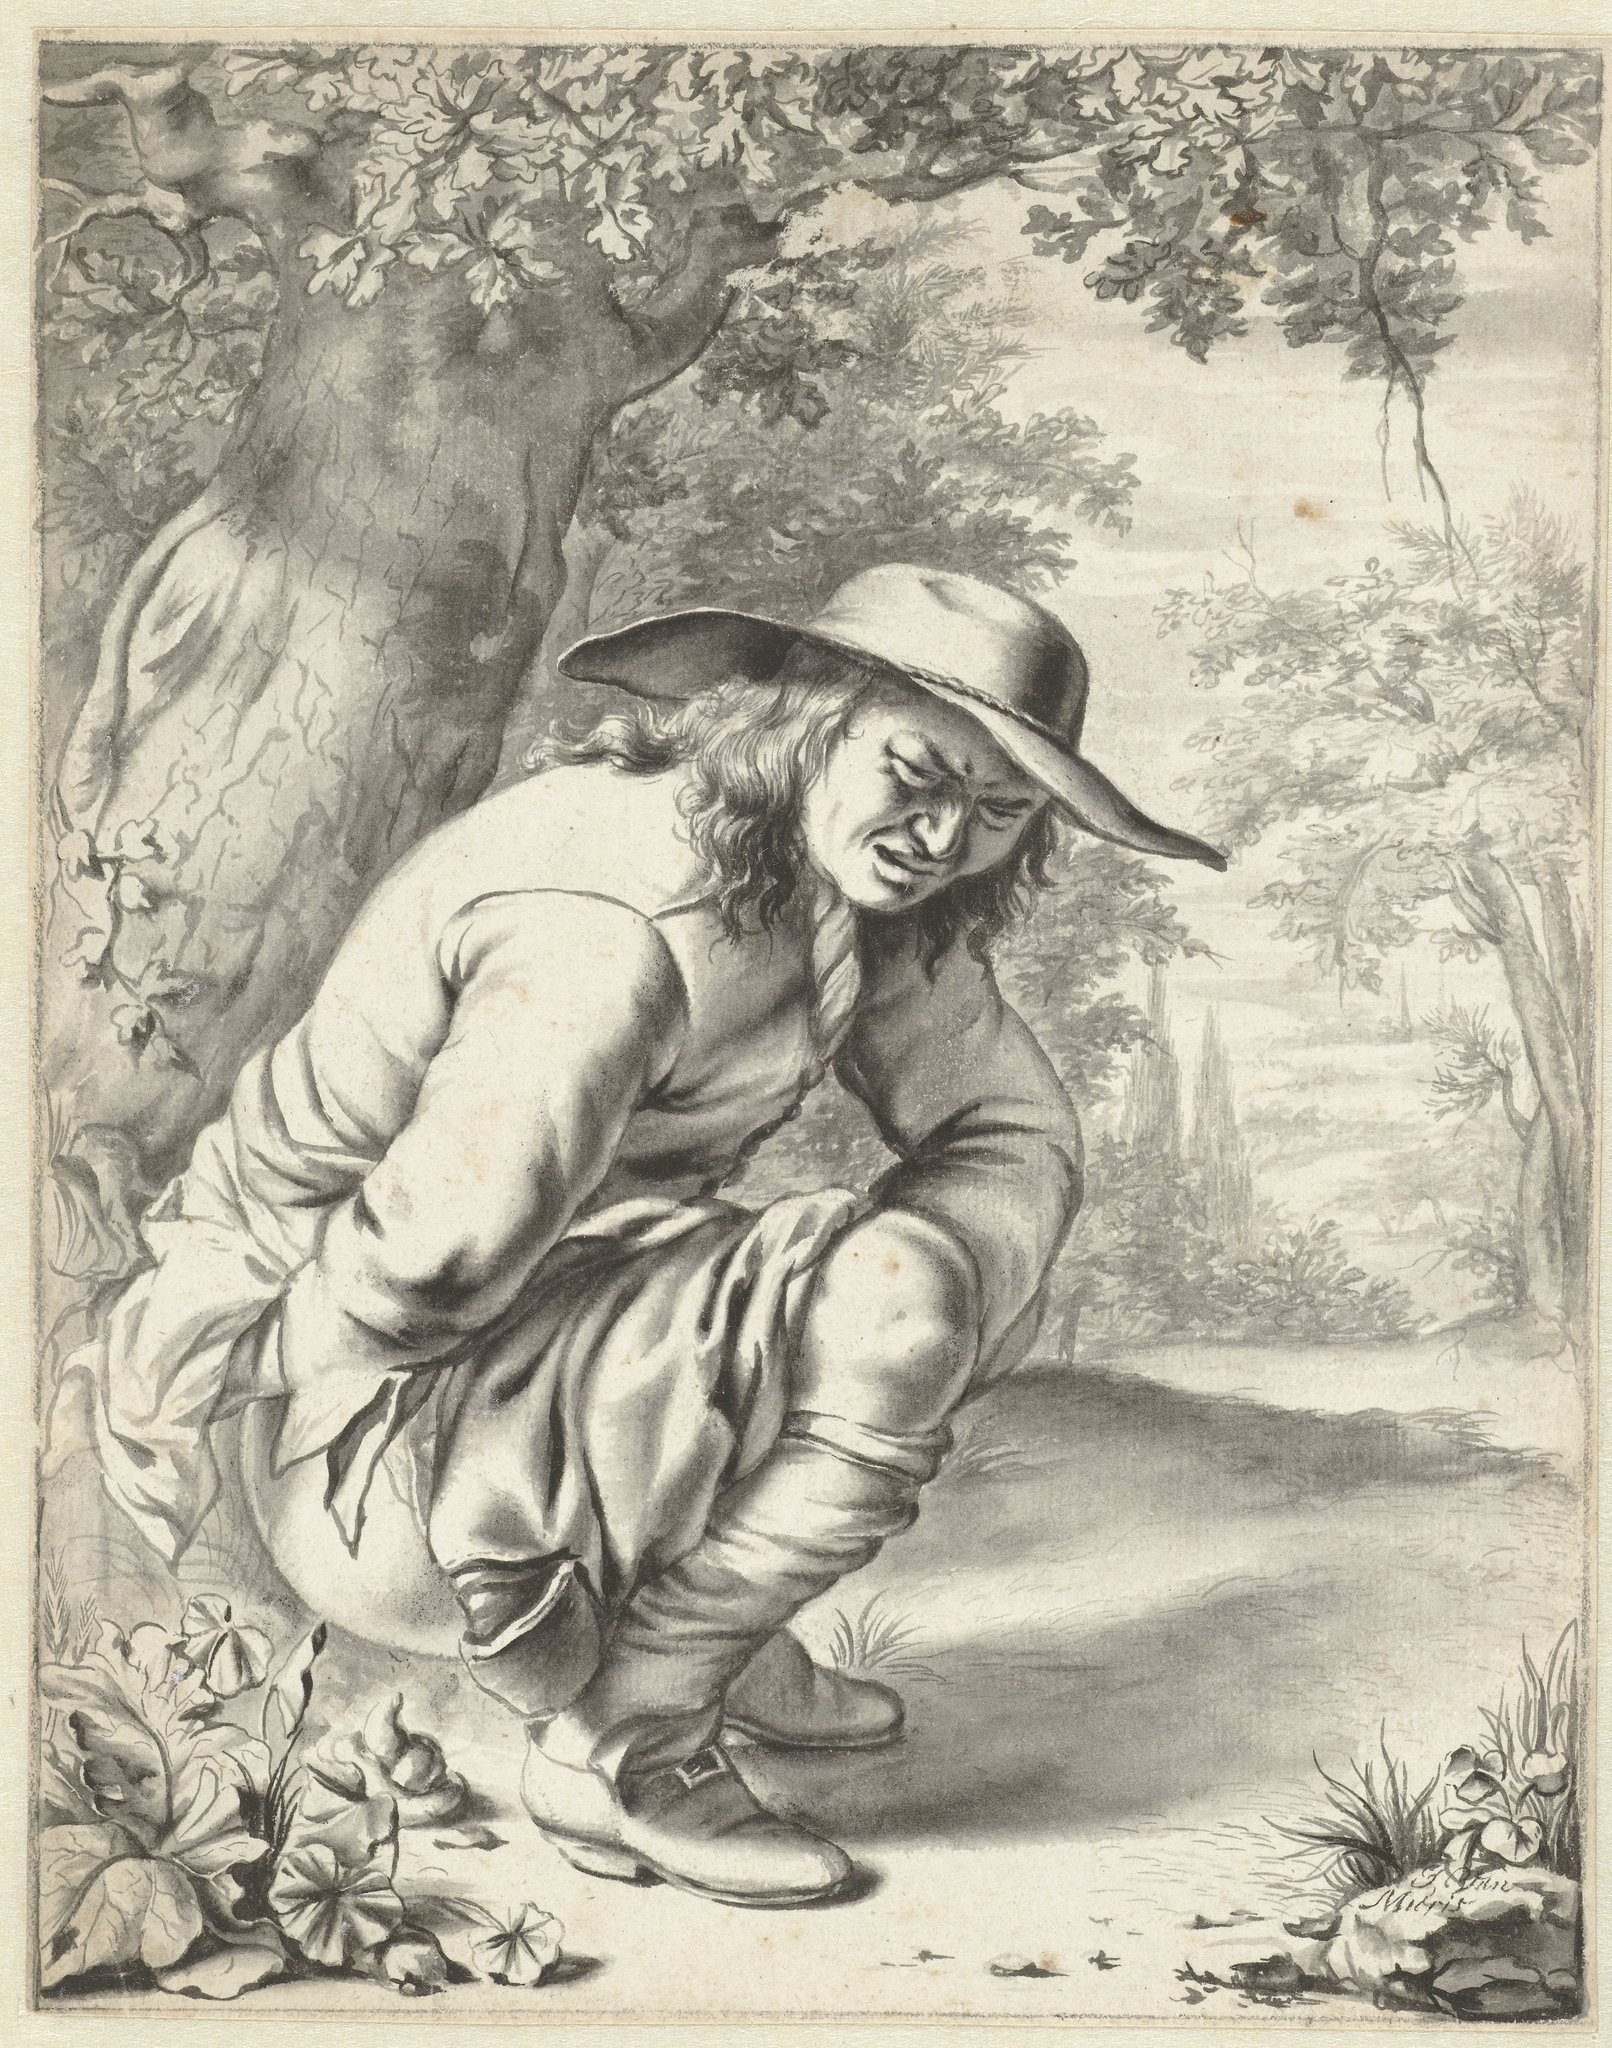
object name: drawing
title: Een man doet hurkend zijn behoefte bij een boom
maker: jan van mieris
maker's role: draughtsman, painter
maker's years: 1660-1690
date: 1670-1690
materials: ink, paper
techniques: brush, pen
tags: defecation